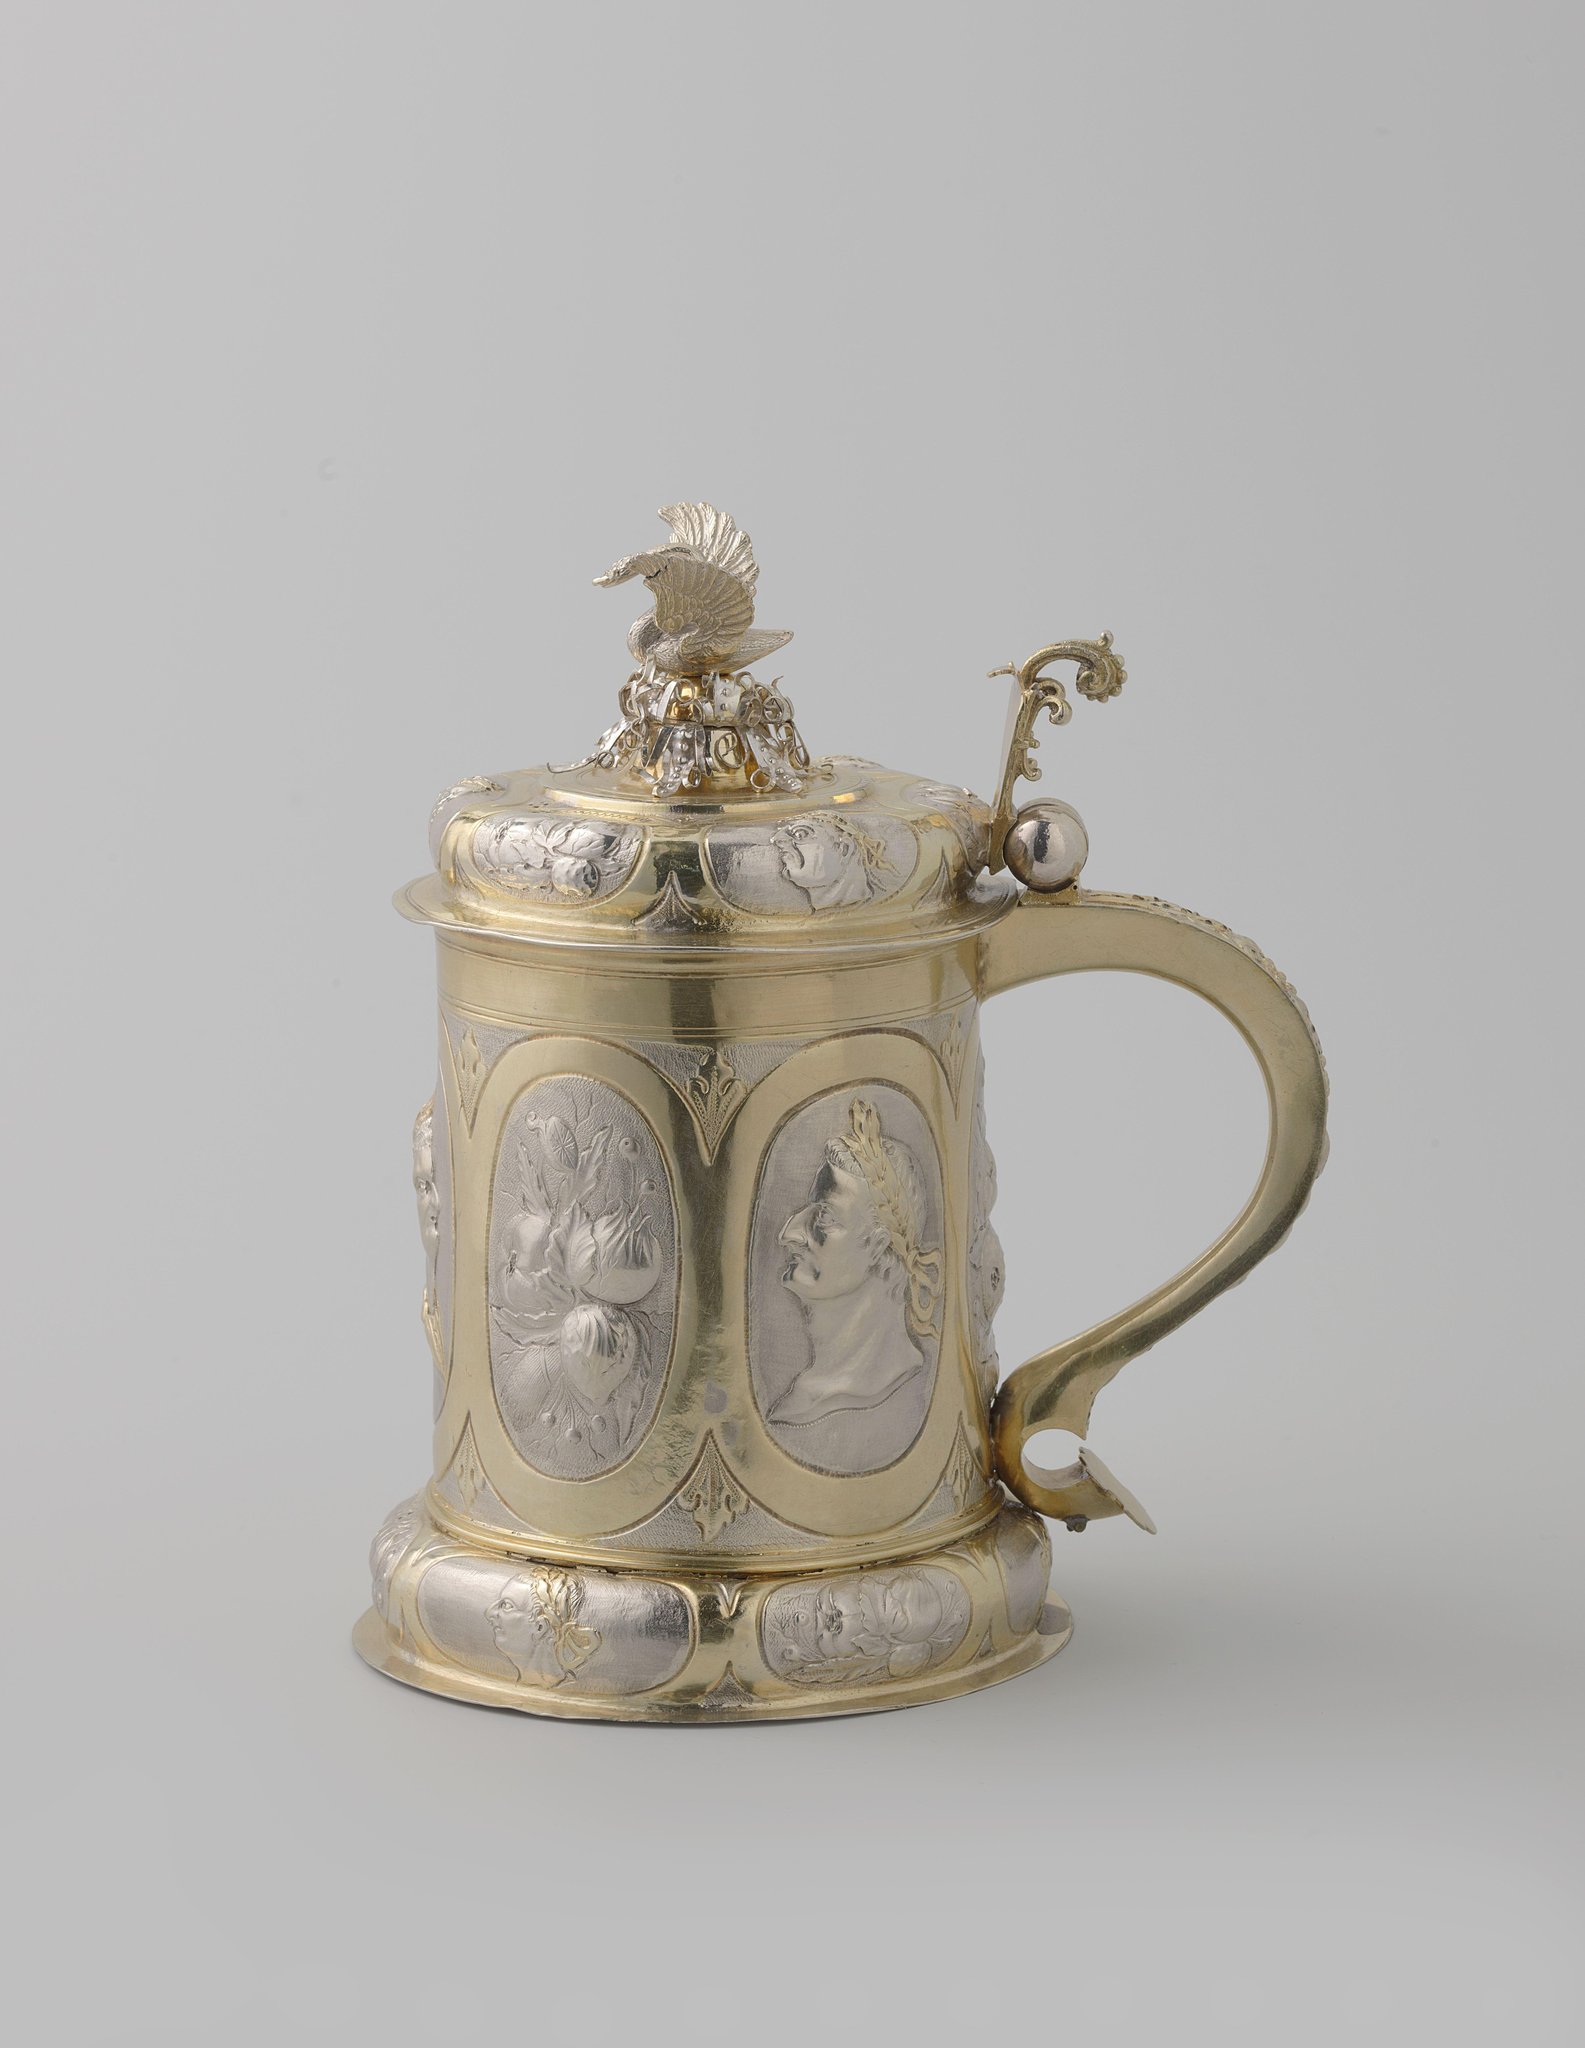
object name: cup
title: Bierpul van zilver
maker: jacob pfaff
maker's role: silversmith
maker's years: -1708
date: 1685-1700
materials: silver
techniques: gilding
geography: nuremberg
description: Cylindervormige schenkkan of beker van zilver, met oor en deksel. Op de kuip 6 ovale medaillons waarin afwisselend de kop van een Romeinse keizer en een tros bloemen of vruchten. Meesterteken: IP waaronder een ster, in schild.